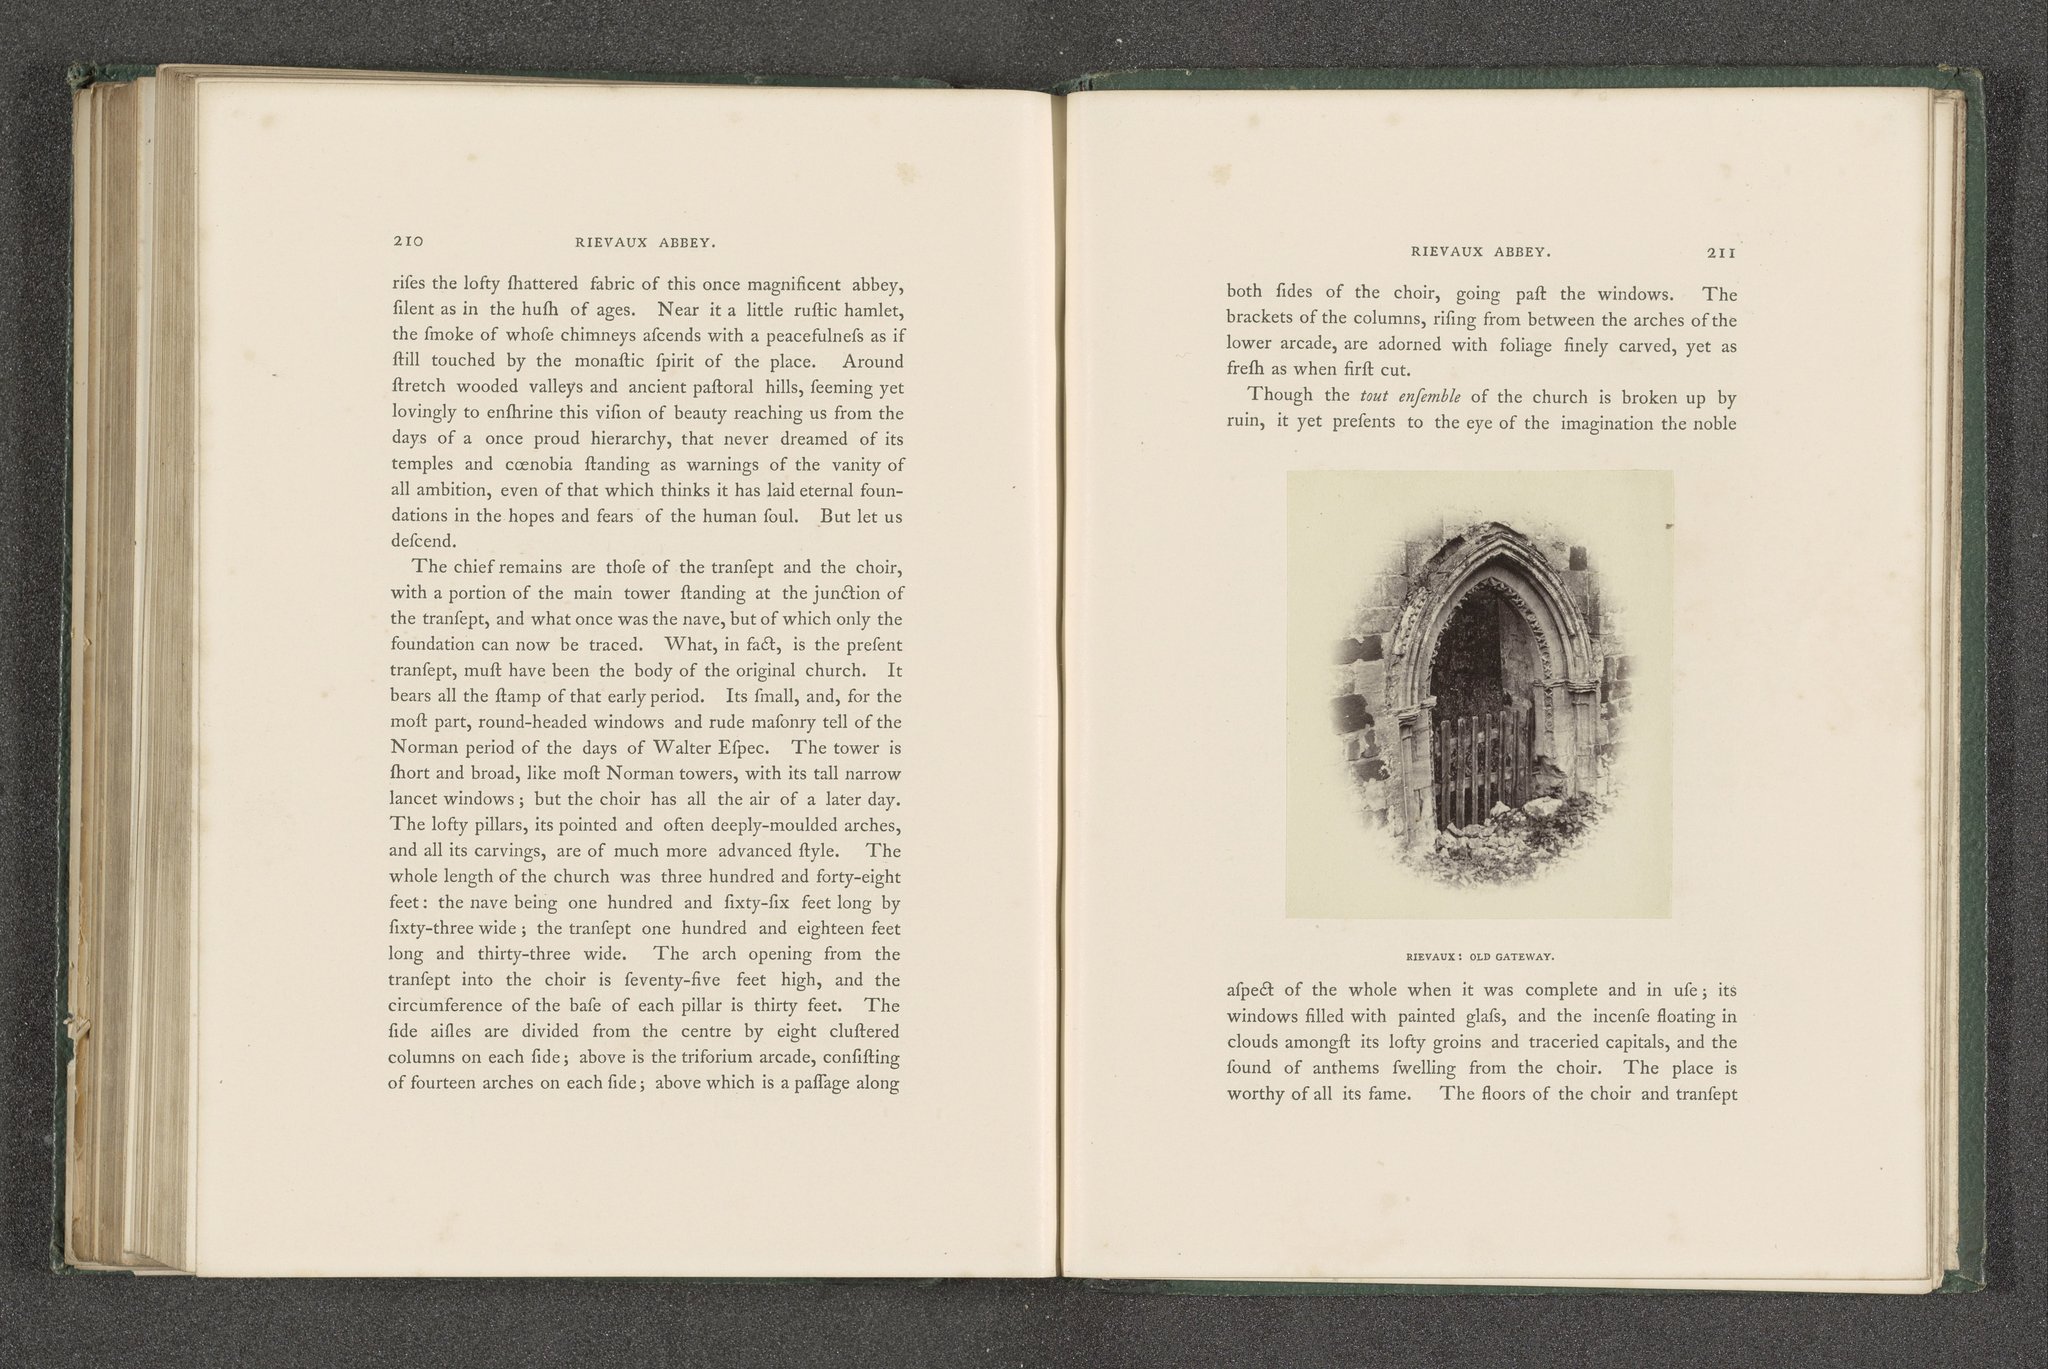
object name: photograph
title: Rievaux : Old Gateway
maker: william russell sedgfield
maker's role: fotograaf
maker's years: 1826-1902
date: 1852-1862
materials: photographic support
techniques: albumen print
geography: rievalx abbey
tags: gate, entrance, ruin of church, monastery, etc.